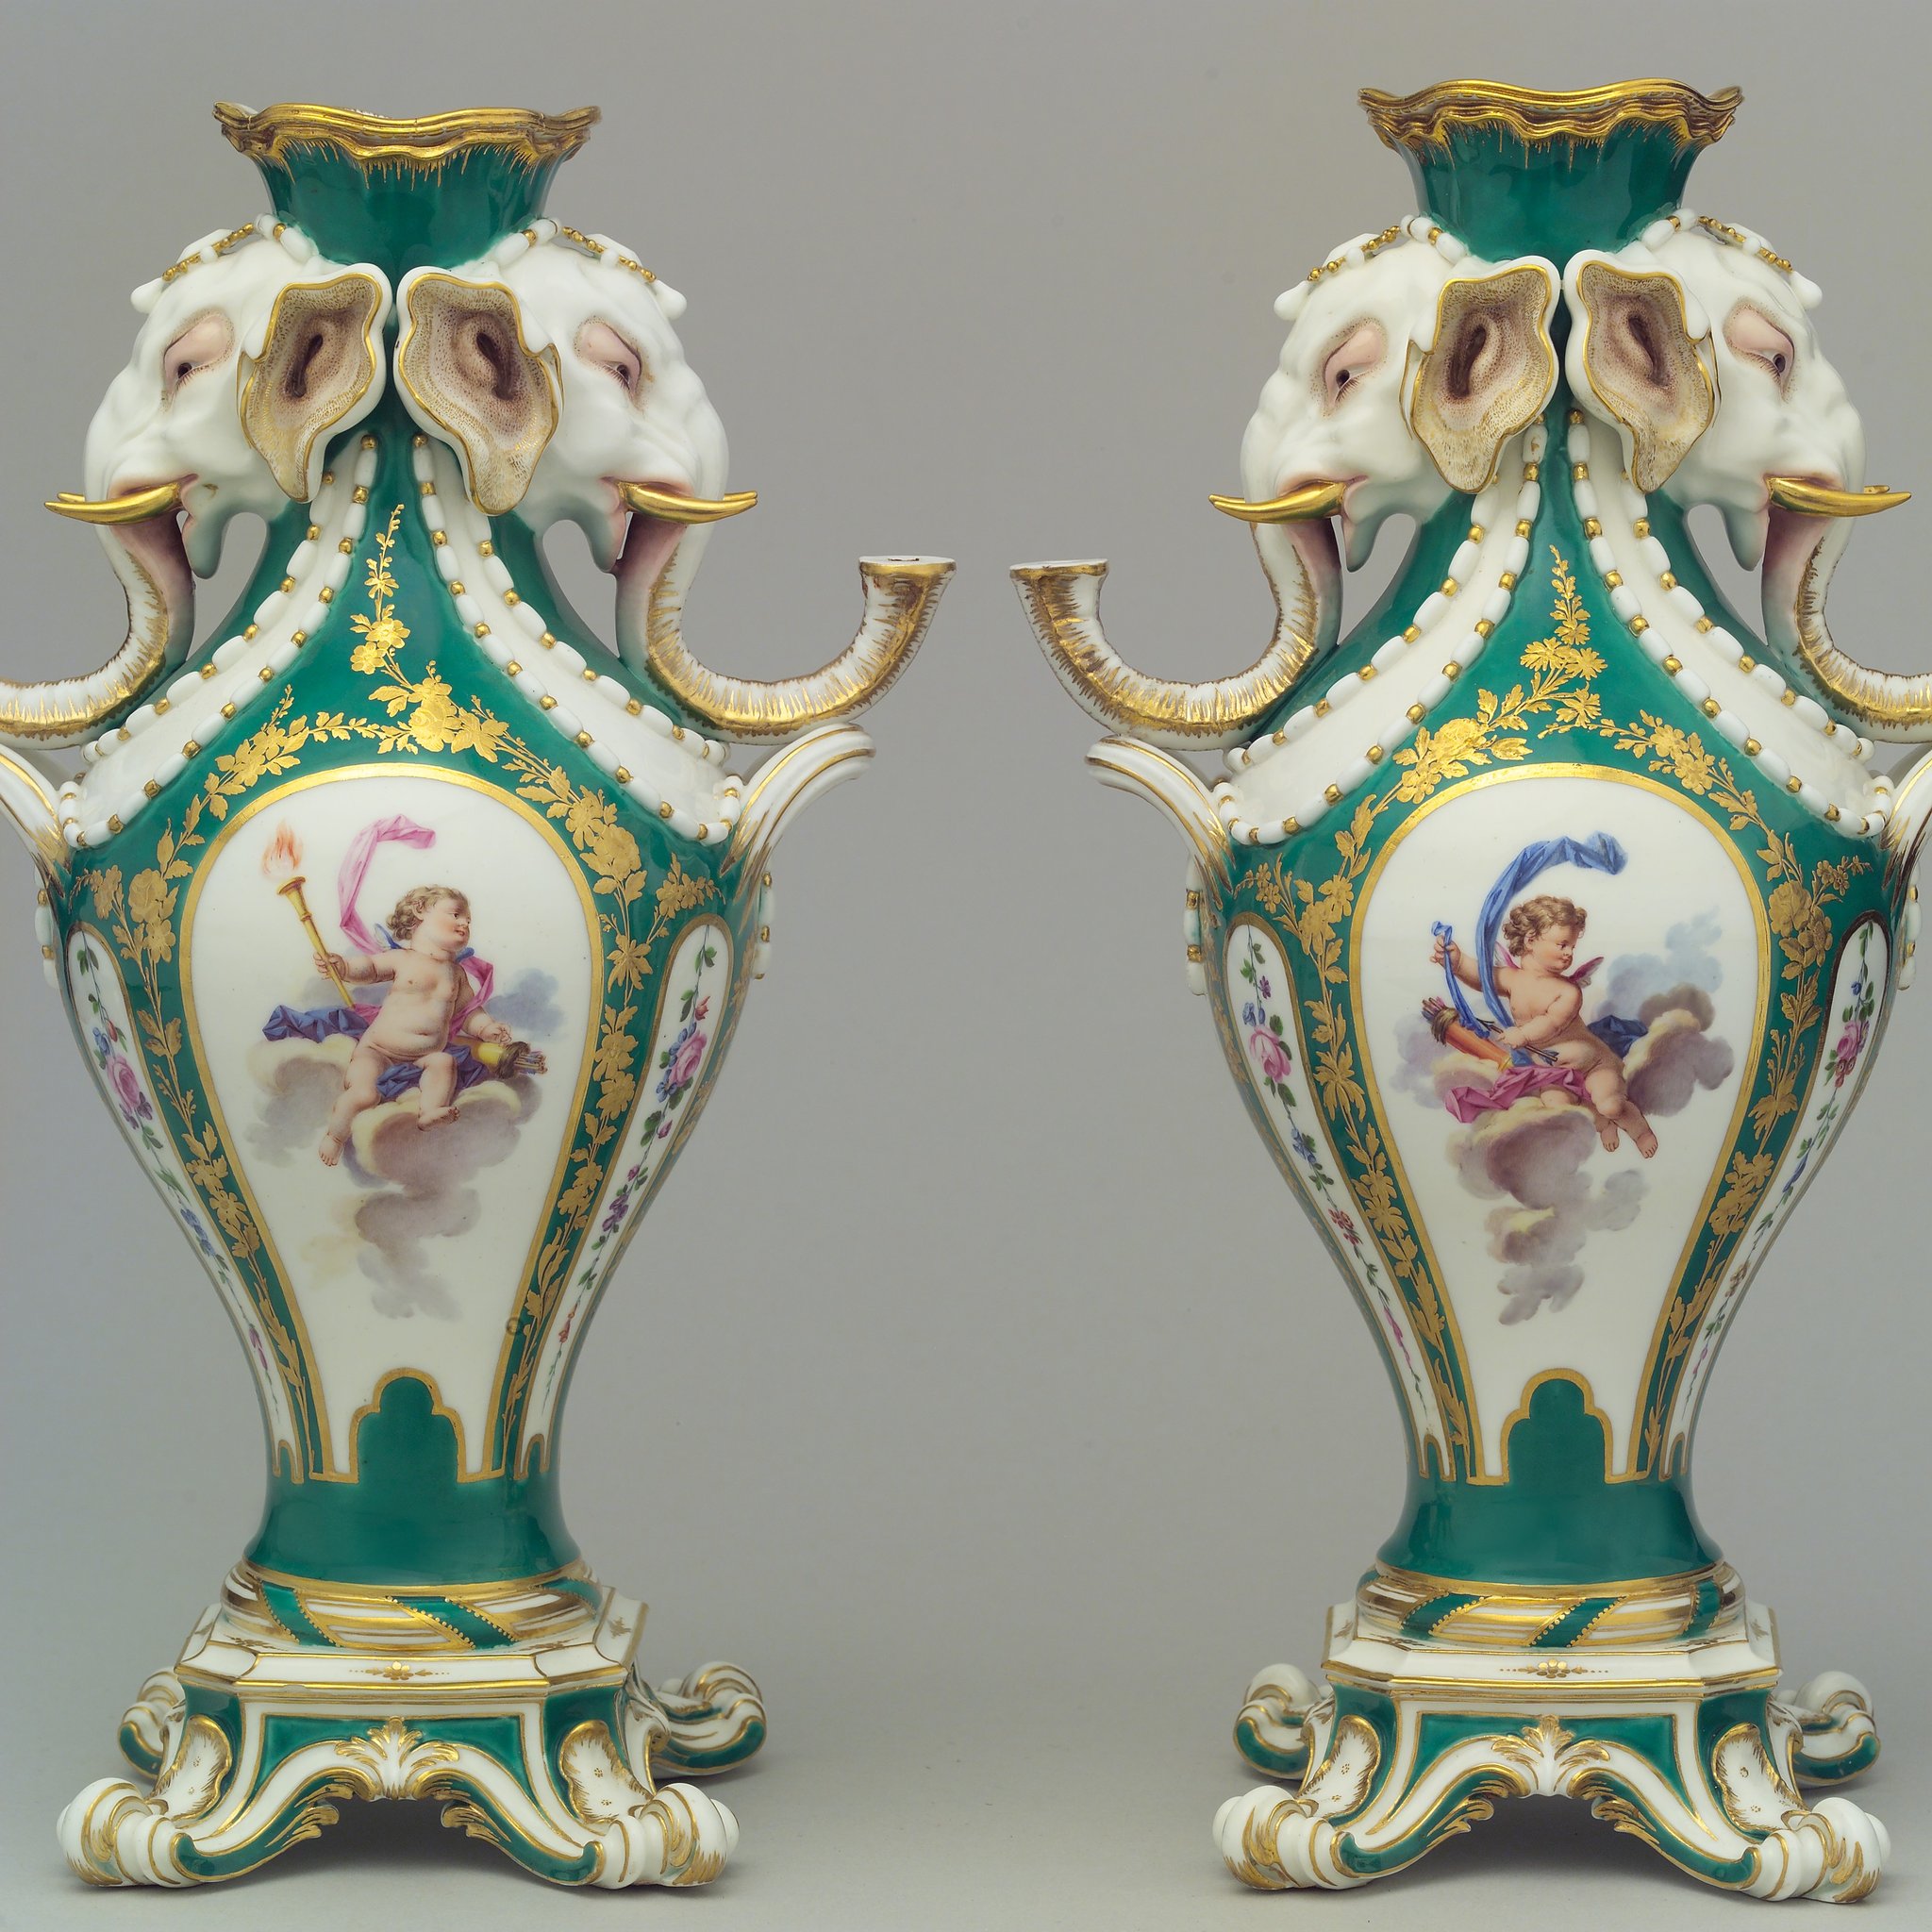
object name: vase pair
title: Pair of elephant-head vases (vases à tête d'éléphant)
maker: sèvres manufactory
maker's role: manufactory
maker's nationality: french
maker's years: 1740-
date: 1758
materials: soft paste porcelain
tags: elephants